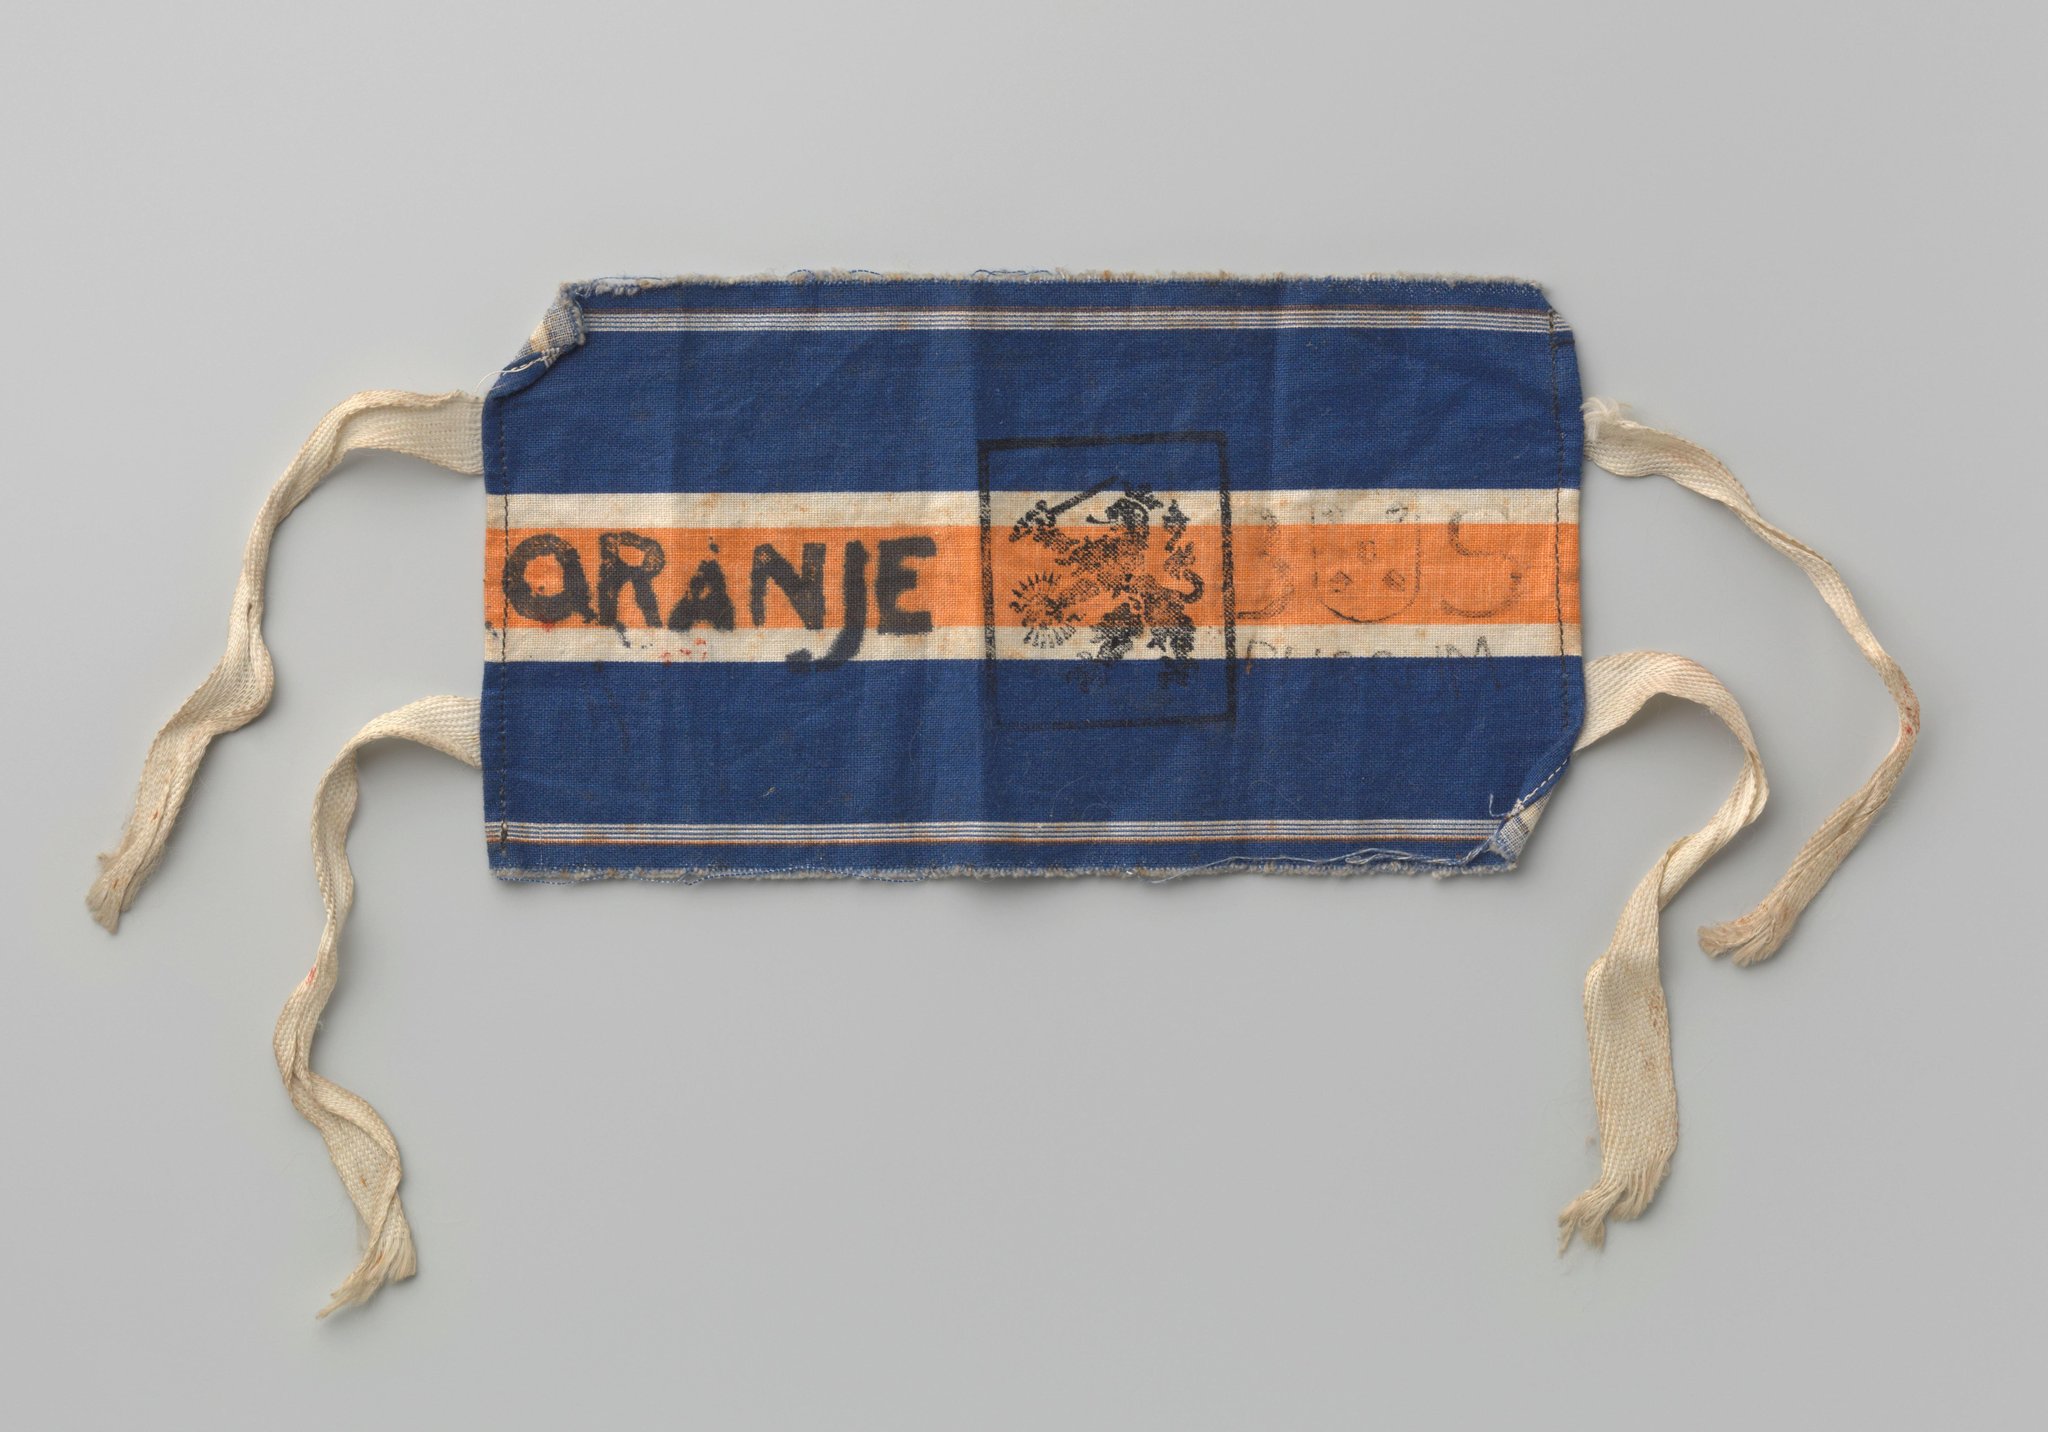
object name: band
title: Band van de Binnenlandse Strijdkrachten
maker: Anonymous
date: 1945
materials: textile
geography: netherlands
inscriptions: : ‘ORANJE’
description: Blauwe band van de Binnenlandse Strijdkrachten met aan weerszijden twee witte linten om de band om de bovenarm te kunnen strikken. Over de band loopt in de gehele breedte een oranje streep met aan weerszijden een witte rand. In het oranje deel staat met zwarte inkt 'ORANJE' geschreven, darnaast staat in een staande rechthoek een zwarte klimmende leeuw.